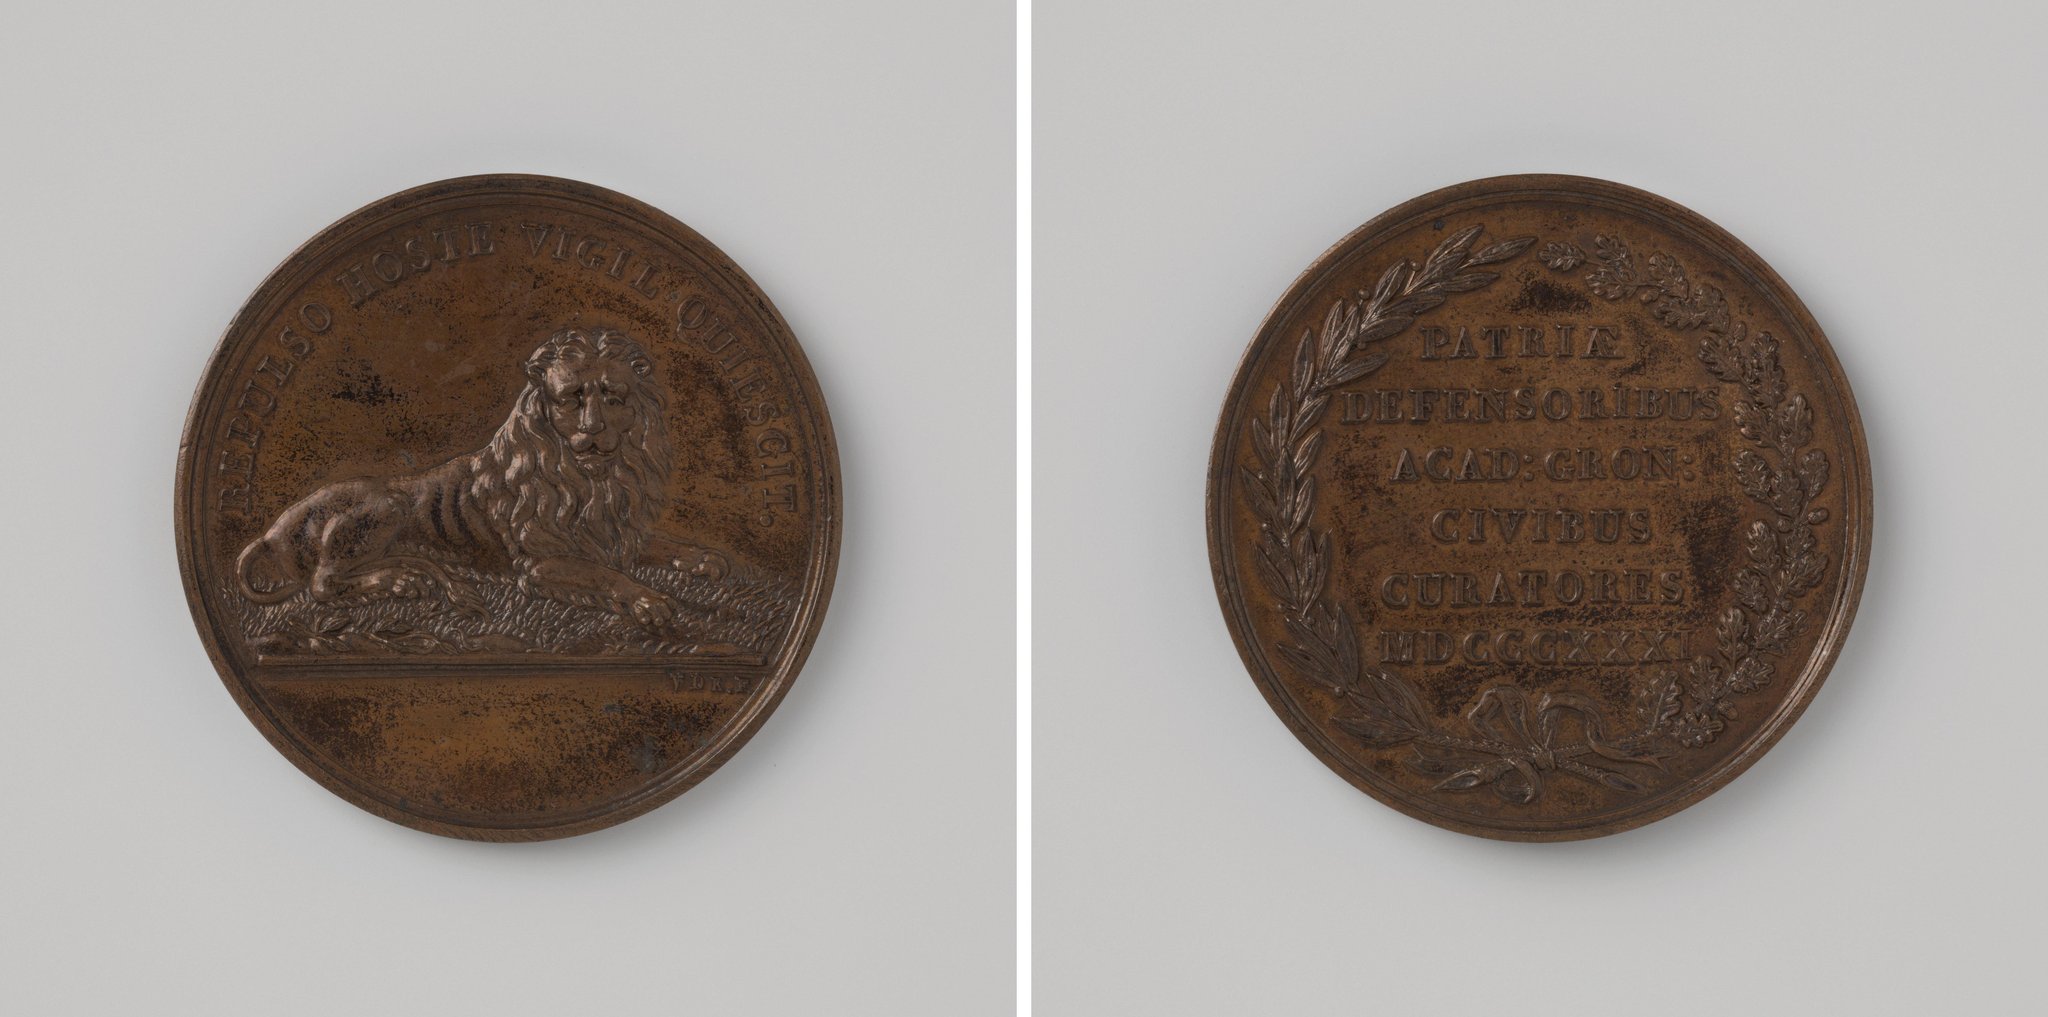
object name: history medal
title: Hulde van de Curatoren der Groninger Akademie aan de uitgetrokken Groninger en Franeker studenten 1831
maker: david van der kellen (1804-1879)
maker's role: die cutter, draughtsman, print maker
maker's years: 1804-1879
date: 1831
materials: bronze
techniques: striking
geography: utrecht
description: Bronzen penning, op de voorzijde een rustende leeuw naar rechts, met omschrift, op de keerzijde zes regels tekst tussen samengestrikte lauwer- en eikenkrans.